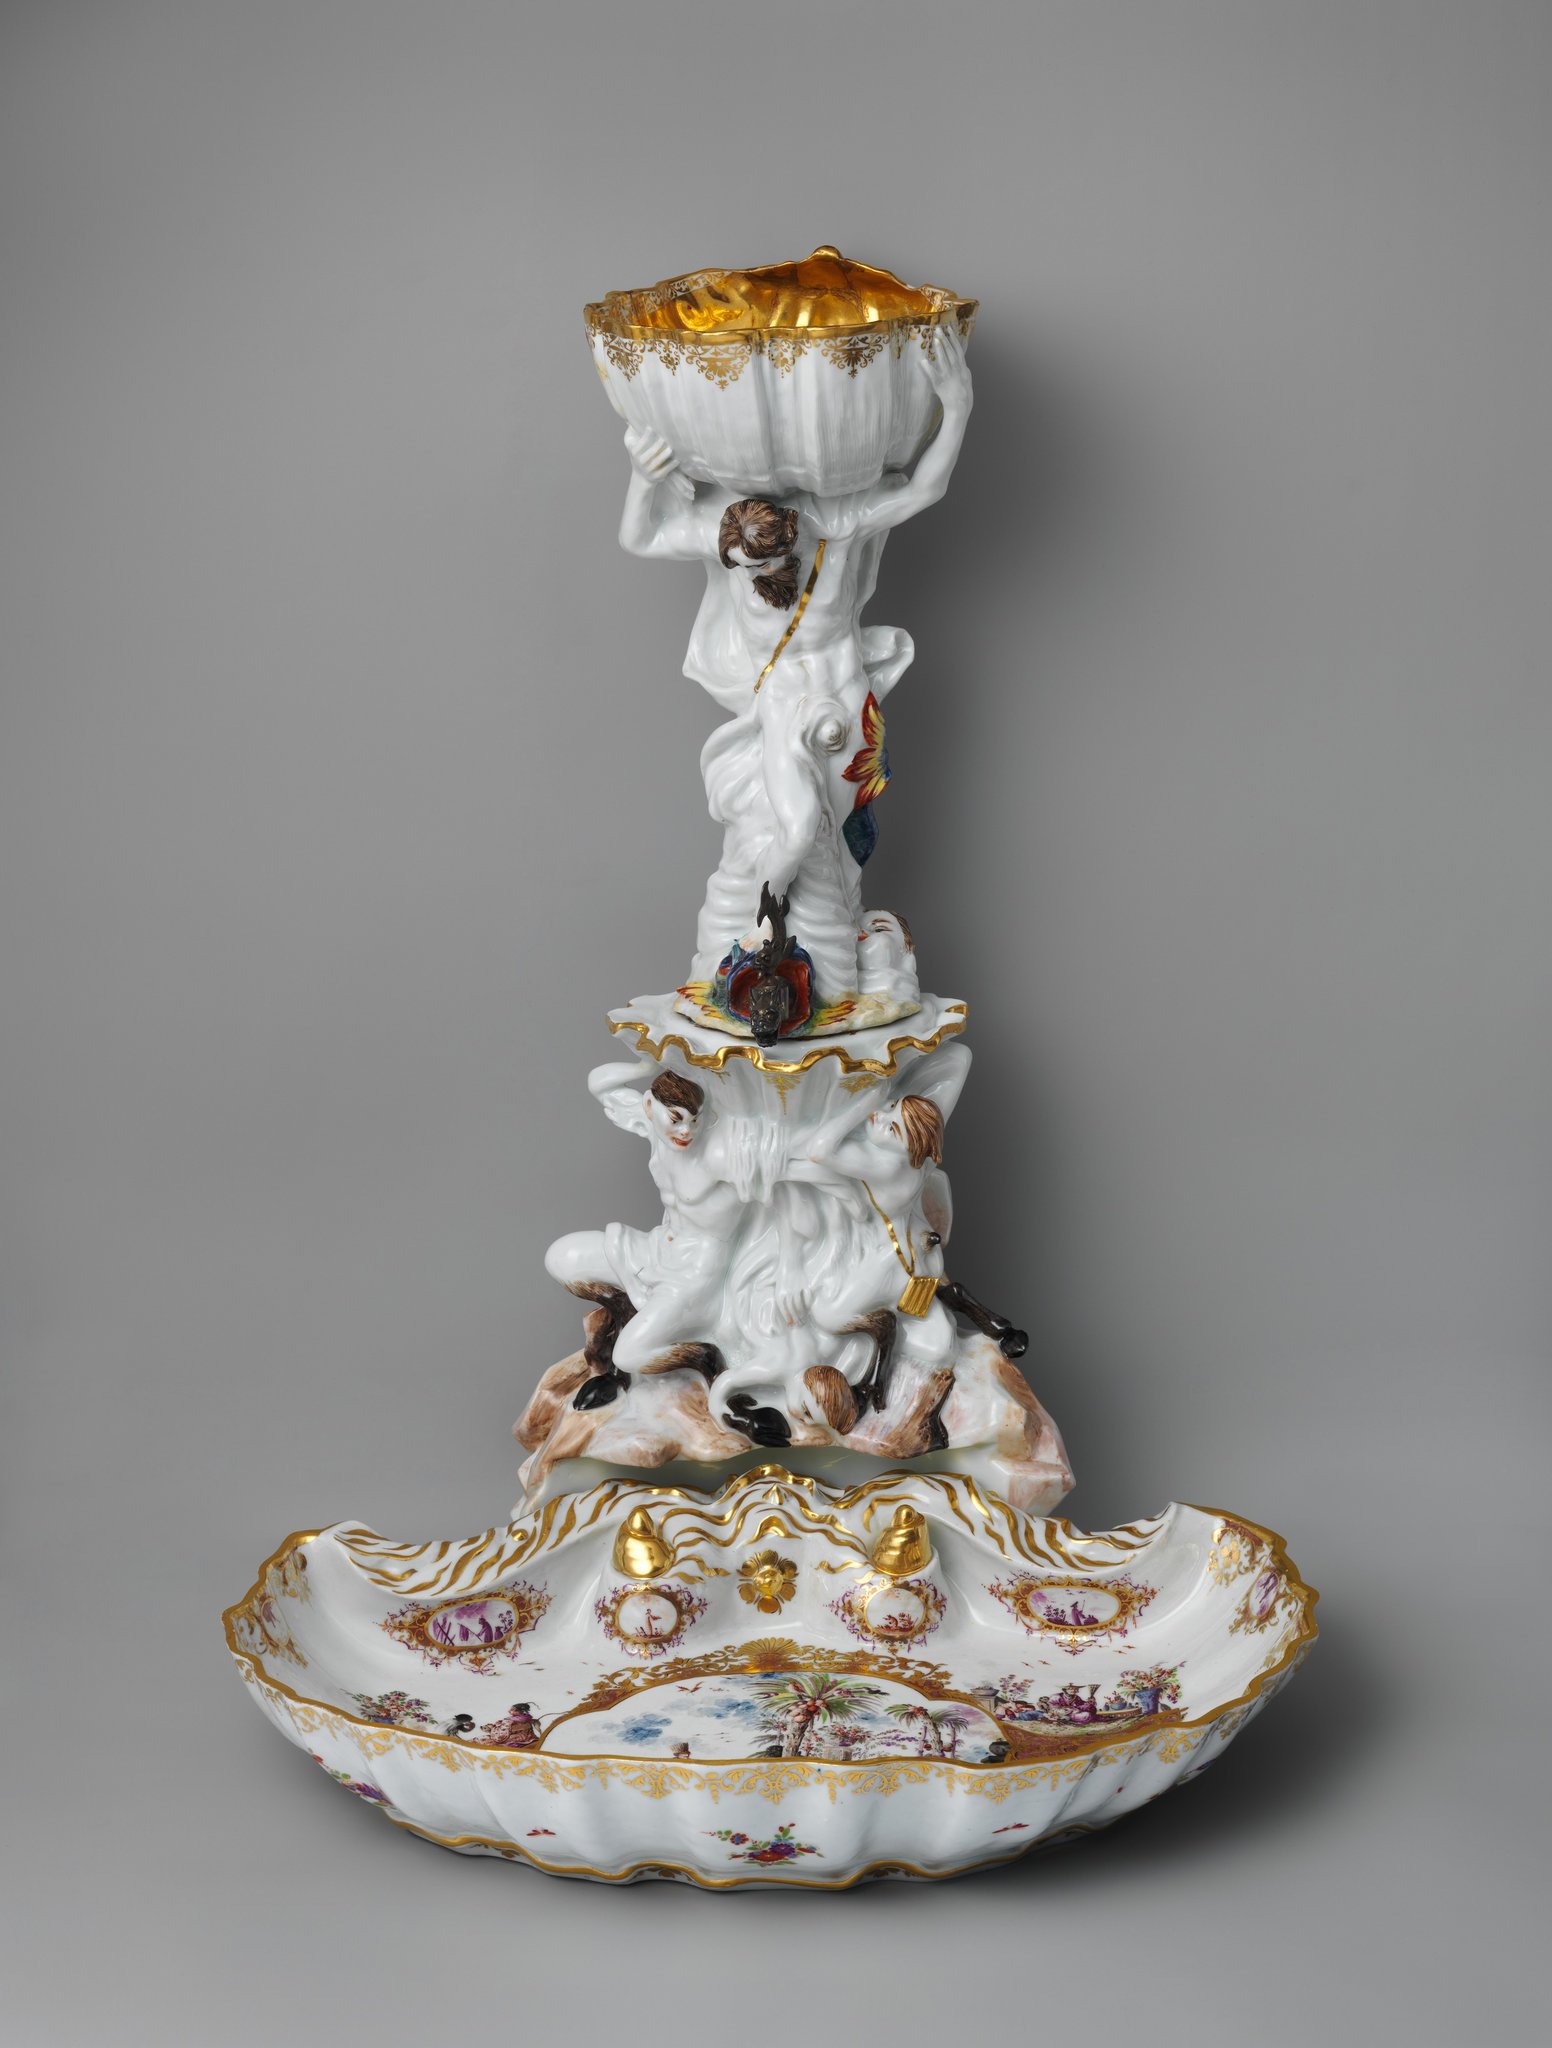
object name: table fountain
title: Fountain and basin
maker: meissen manufactory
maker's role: manufactory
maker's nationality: german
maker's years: 1710-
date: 1727-1732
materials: enamel, gold, hard paste porcelain, silver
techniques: polychrome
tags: fountains